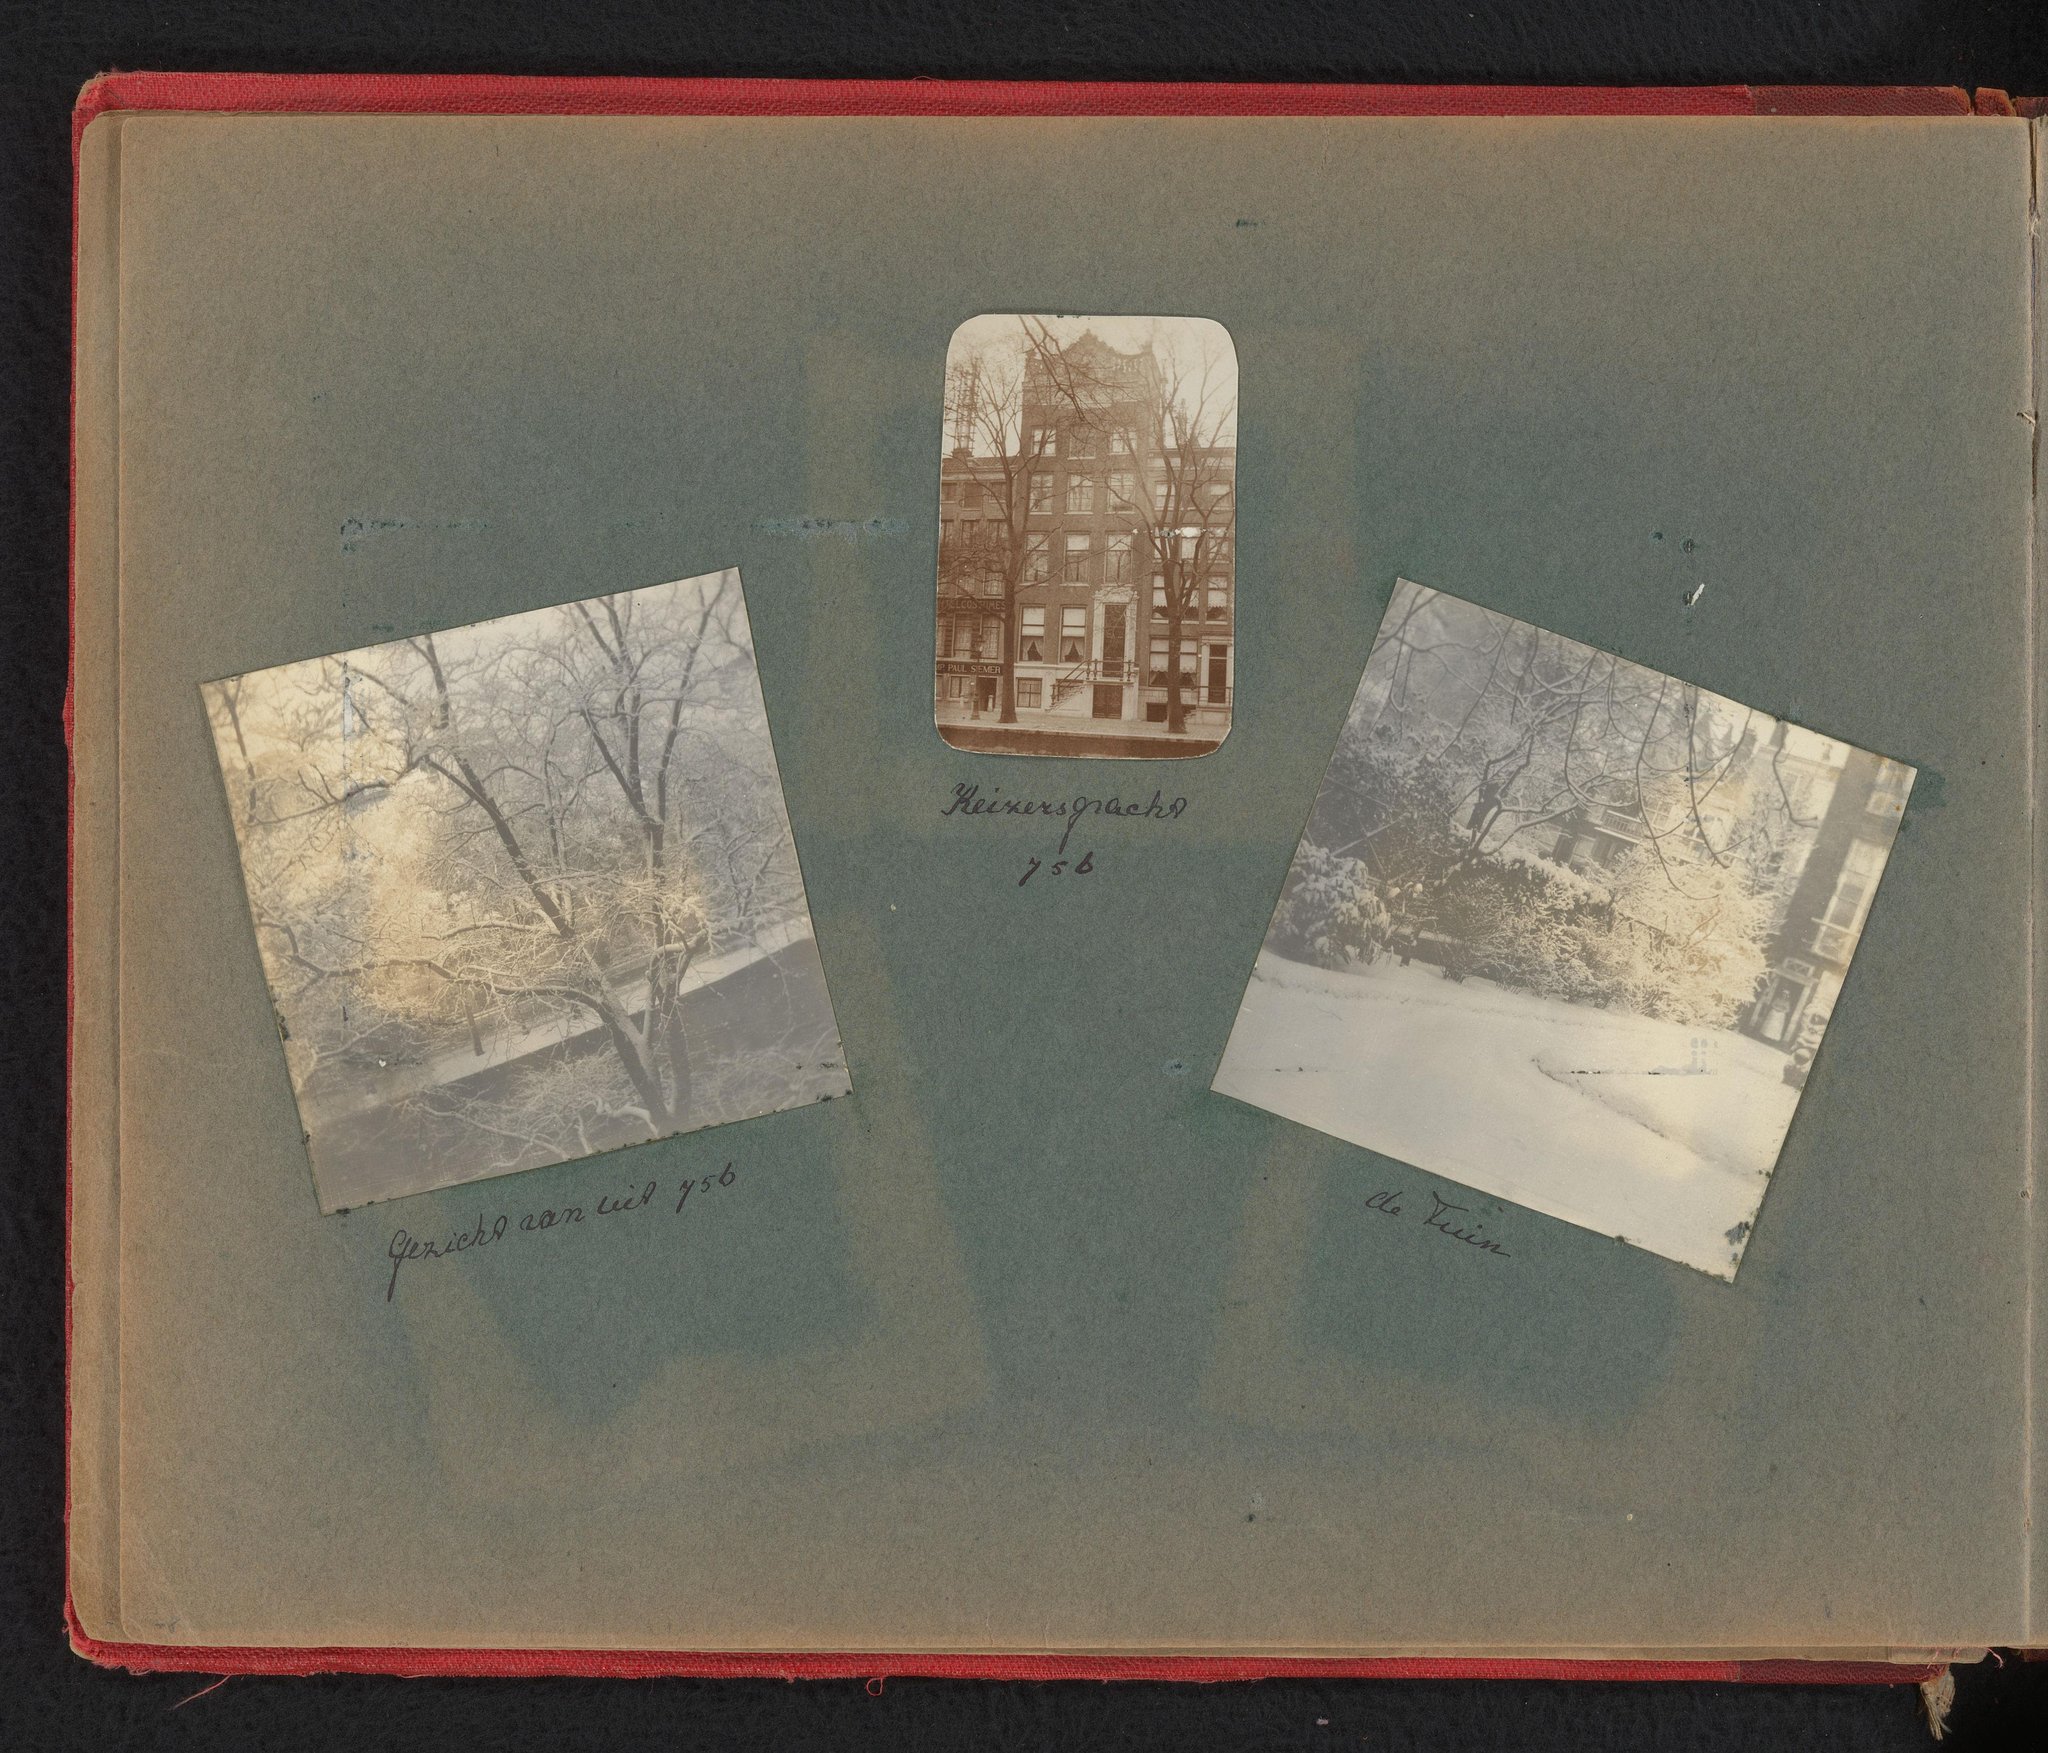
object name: album leaf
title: Drie gezichten op en uit het ouderlijk huis van Charlotte Boelen-Matthes aan Keizersgracht 756 in Amsterdam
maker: charlotte alida boelen-matthes (lot)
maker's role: amateurfotograaf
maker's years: 1889-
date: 1911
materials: paper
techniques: gelatin silver print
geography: amsterdam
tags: urban housing, garden, canals, waters (in city)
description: Deze foto's zijn onderdeel van een album.